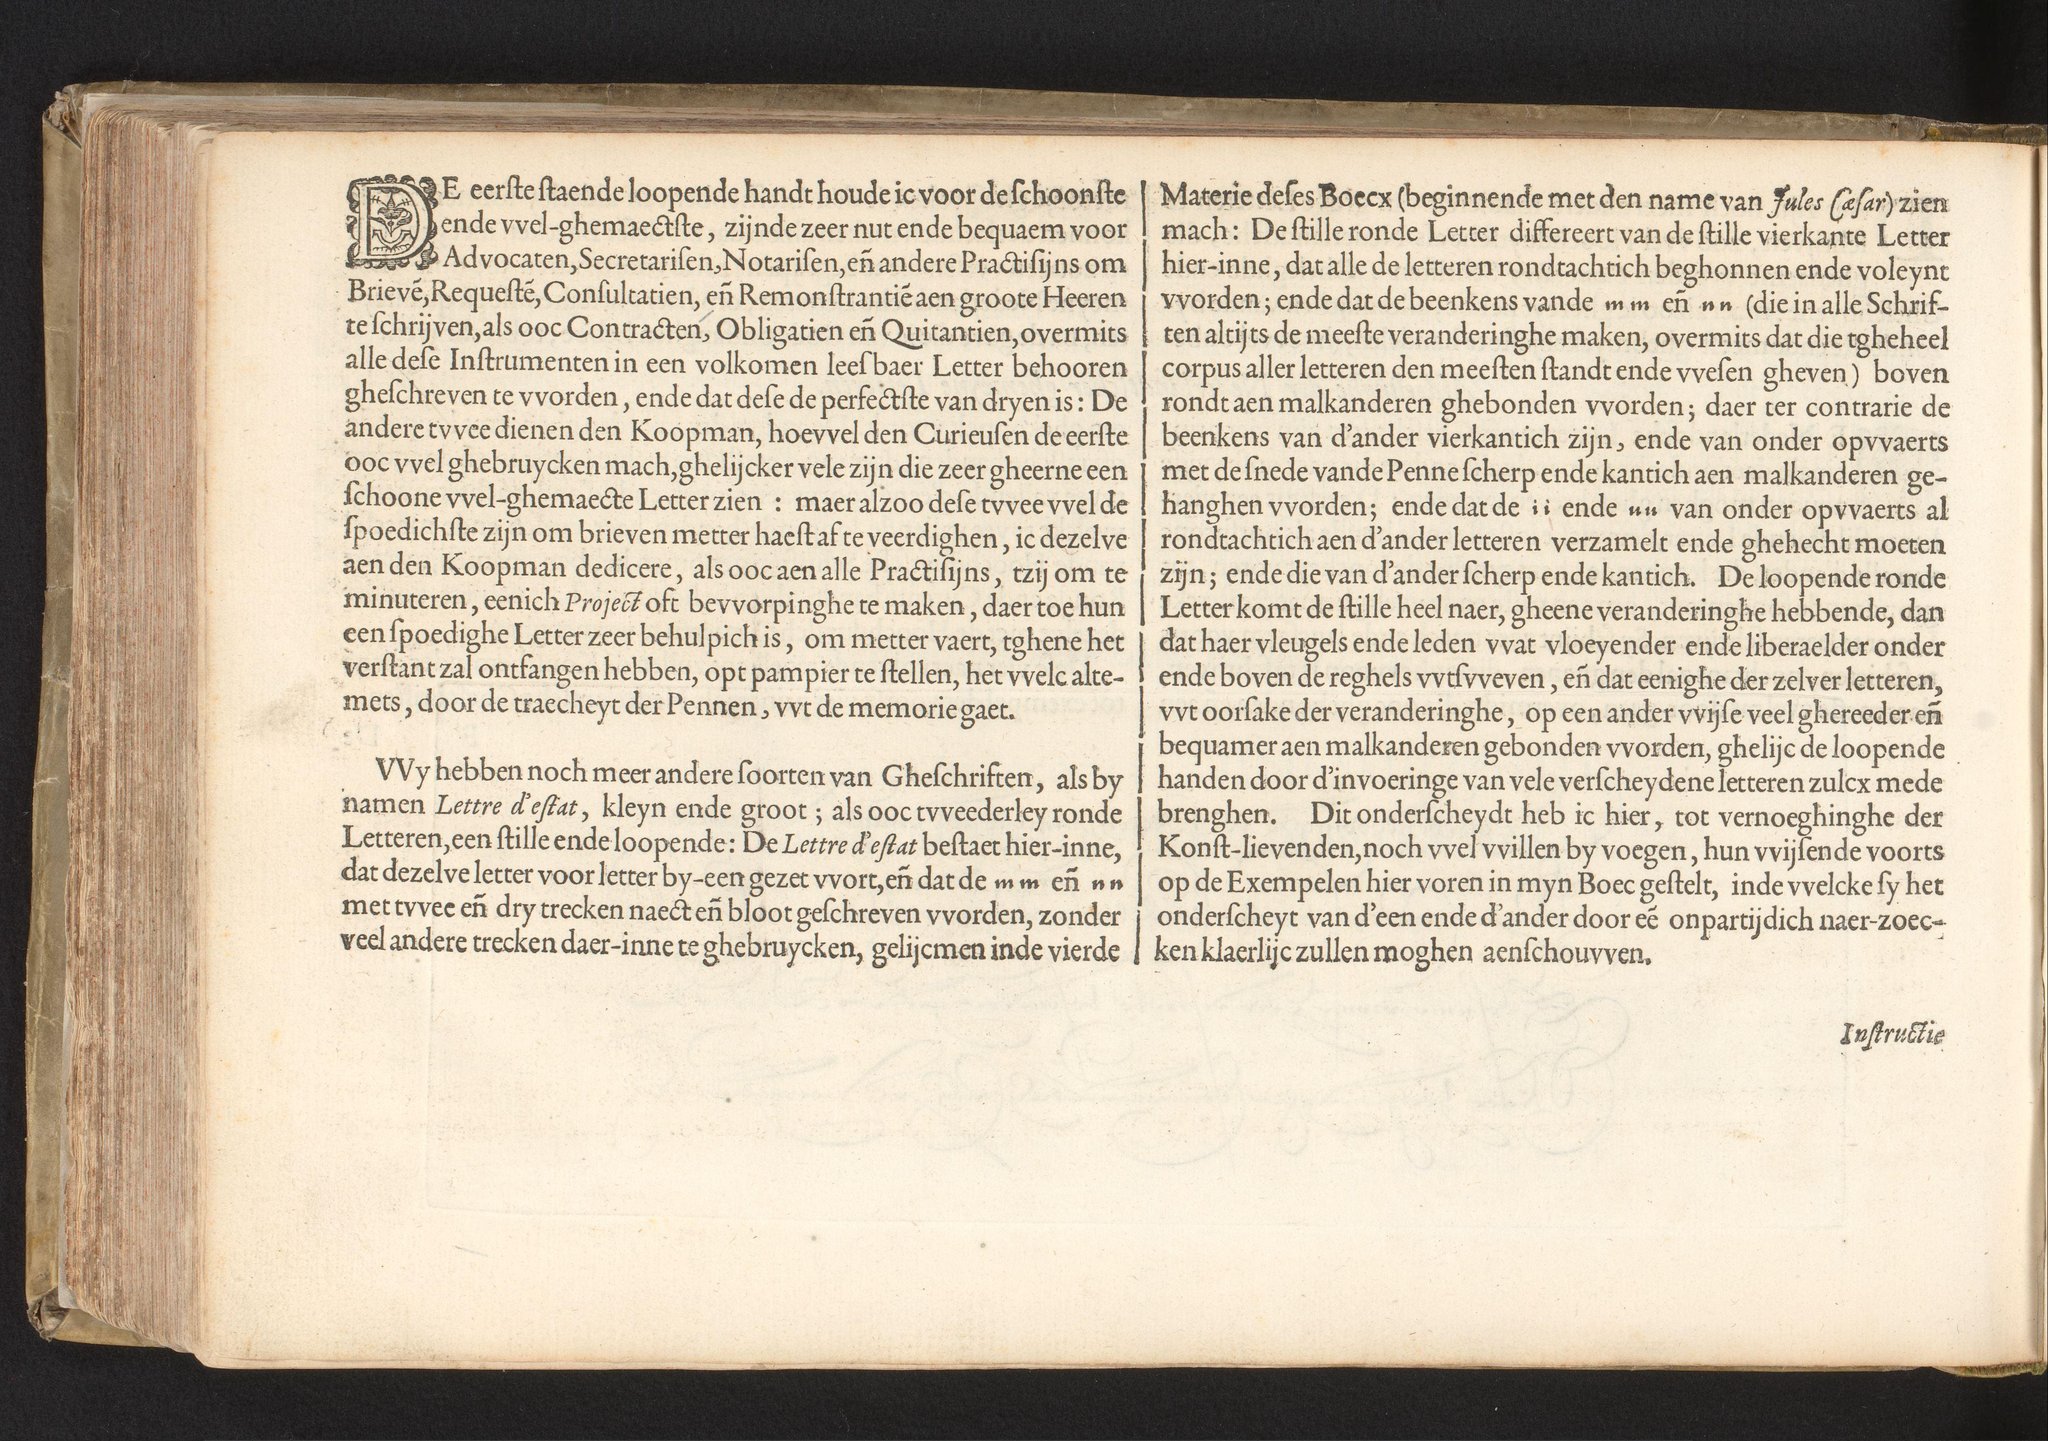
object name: text sheet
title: Fondement-Boeck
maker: jan van de velde (i)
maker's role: painter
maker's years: 1568-1623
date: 1605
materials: paper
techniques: letterpress printing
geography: rotterdam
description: Folio F1v met een beschrijving van verschillende Nederlandse letteren. De tekst vangt aan met een kleine initiaal D. Het blad maakt deel uit van een album.